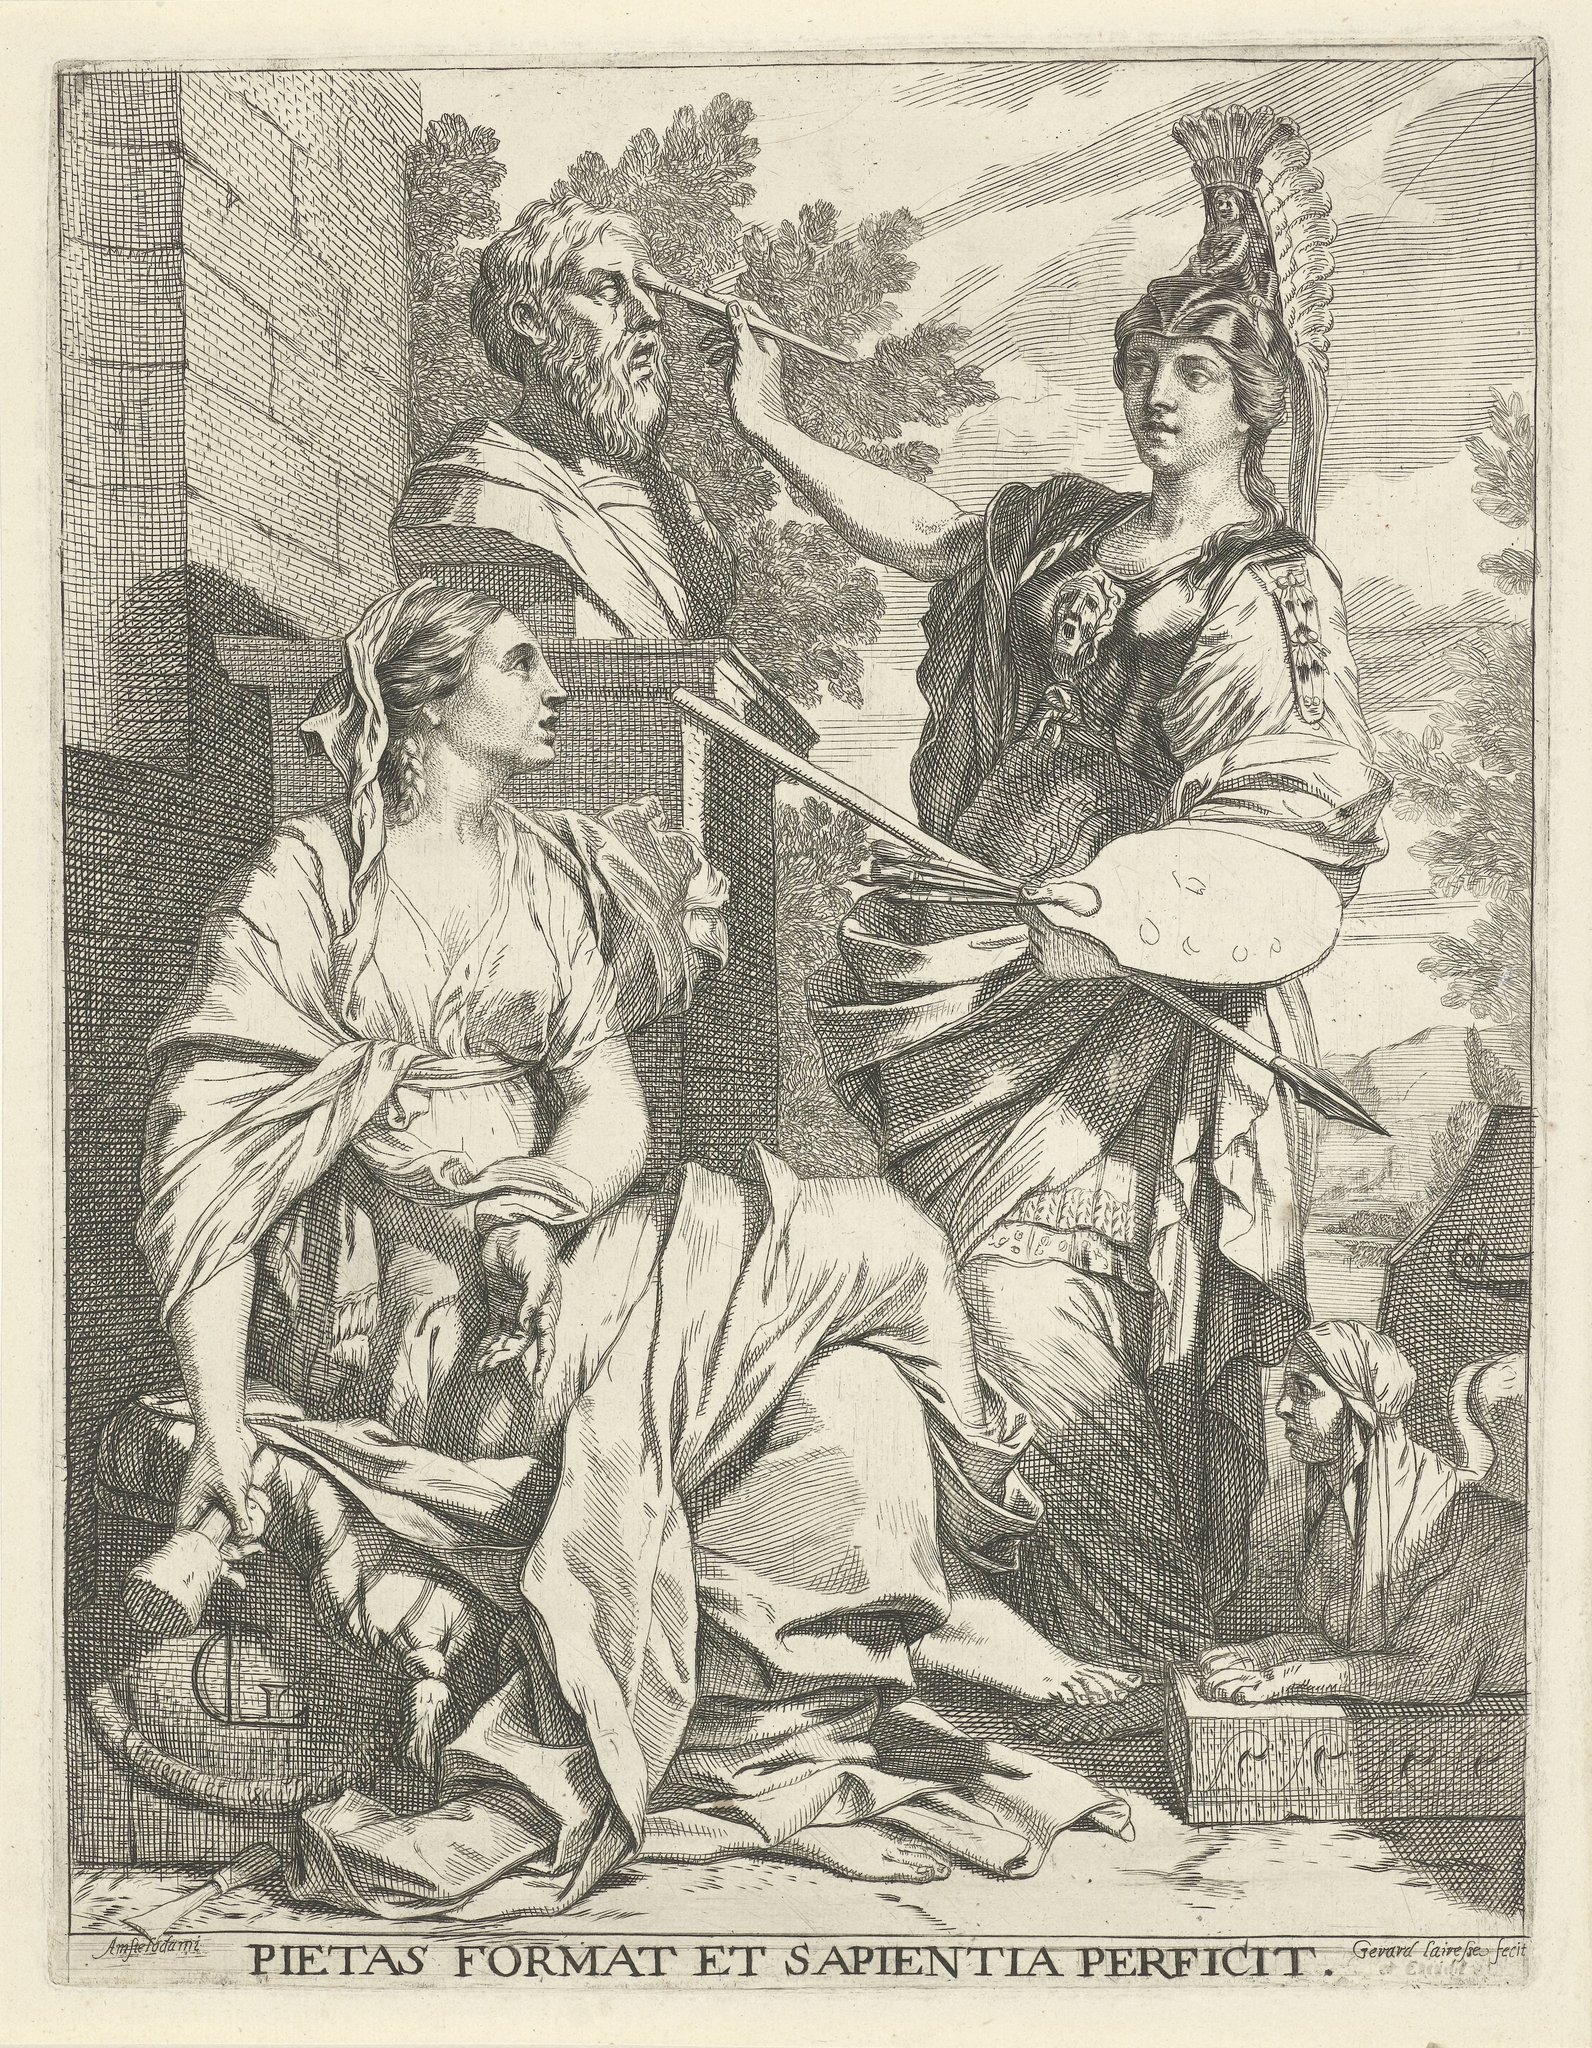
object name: print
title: Allegorie op de beeldhouwkunst en schilderkunst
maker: gerard de lairesse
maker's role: draughtsman, painter, print maker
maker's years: 1641-1711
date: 1670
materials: paper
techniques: etching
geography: amsterdam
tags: 'pictura', symbolic representations, allegories and emblems ~ painting; 'pittura' (ripa), 'sculptura', symbolic representations, allegories and emblems ~ sculpture; 'scoltura' (ripa)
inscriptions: collector's mark: Lugt 240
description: De personificatie van schilderkunst staat met een kwast, schilderstok en schilderspalet in haar handen en beschildert het door de Beeldhouwkunst gehouwen borstbeeld. Links kijkt de gepersonifieerde beeldhouwkunst met een hamer in haar handen toe hoe de Schilderkunst haar werk verricht.